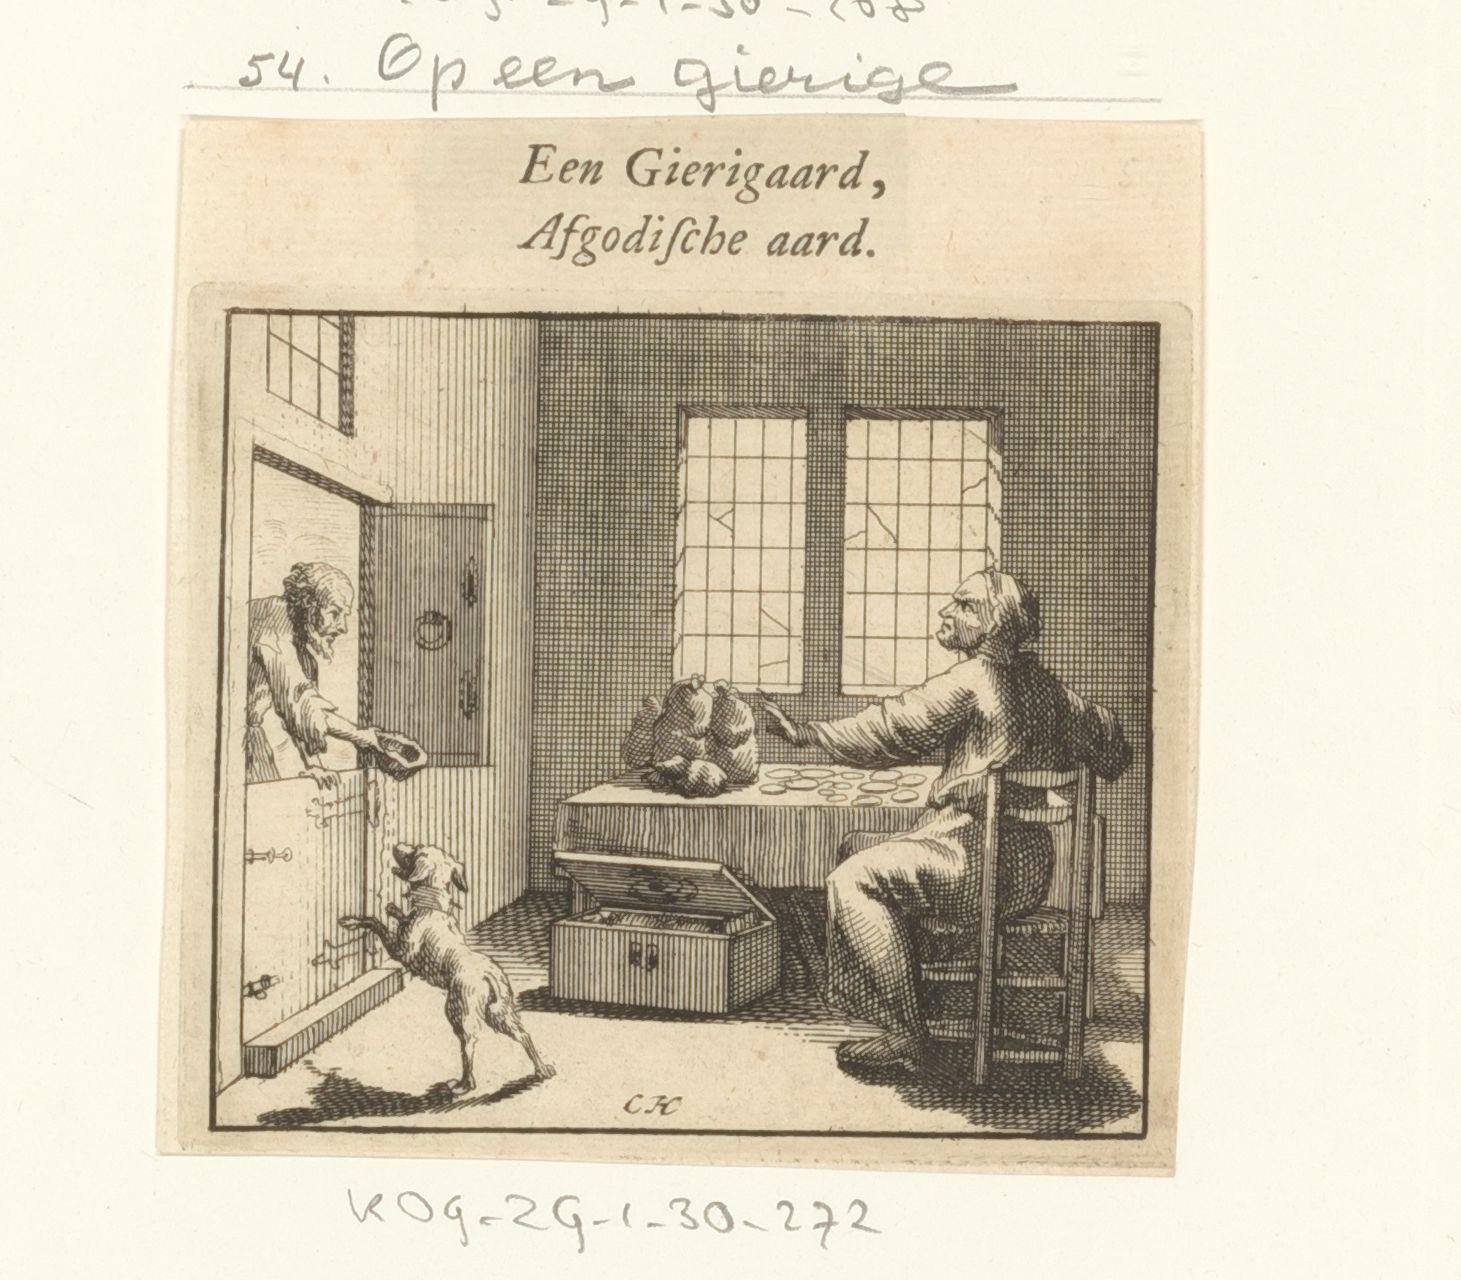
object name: print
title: Gierige man weigert geld tegen aan een arme man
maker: cornelis huyberts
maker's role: print maker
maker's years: 1669-1709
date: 1725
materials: paper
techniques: etching, letterpress printing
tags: miser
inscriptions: collector's mark: Lugt 1641, stamp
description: Prent uit: Graauwhart, Hendrik. Voorbeeldelyke zeede-lessen, genoomen uyt den eersten toestand des werelds (...). Amsterdam: Johannes Ratelband, 1725. Prent ook gebruikt voor eerdere en (1709) latere uitgave (1756, 1761 en 1764).